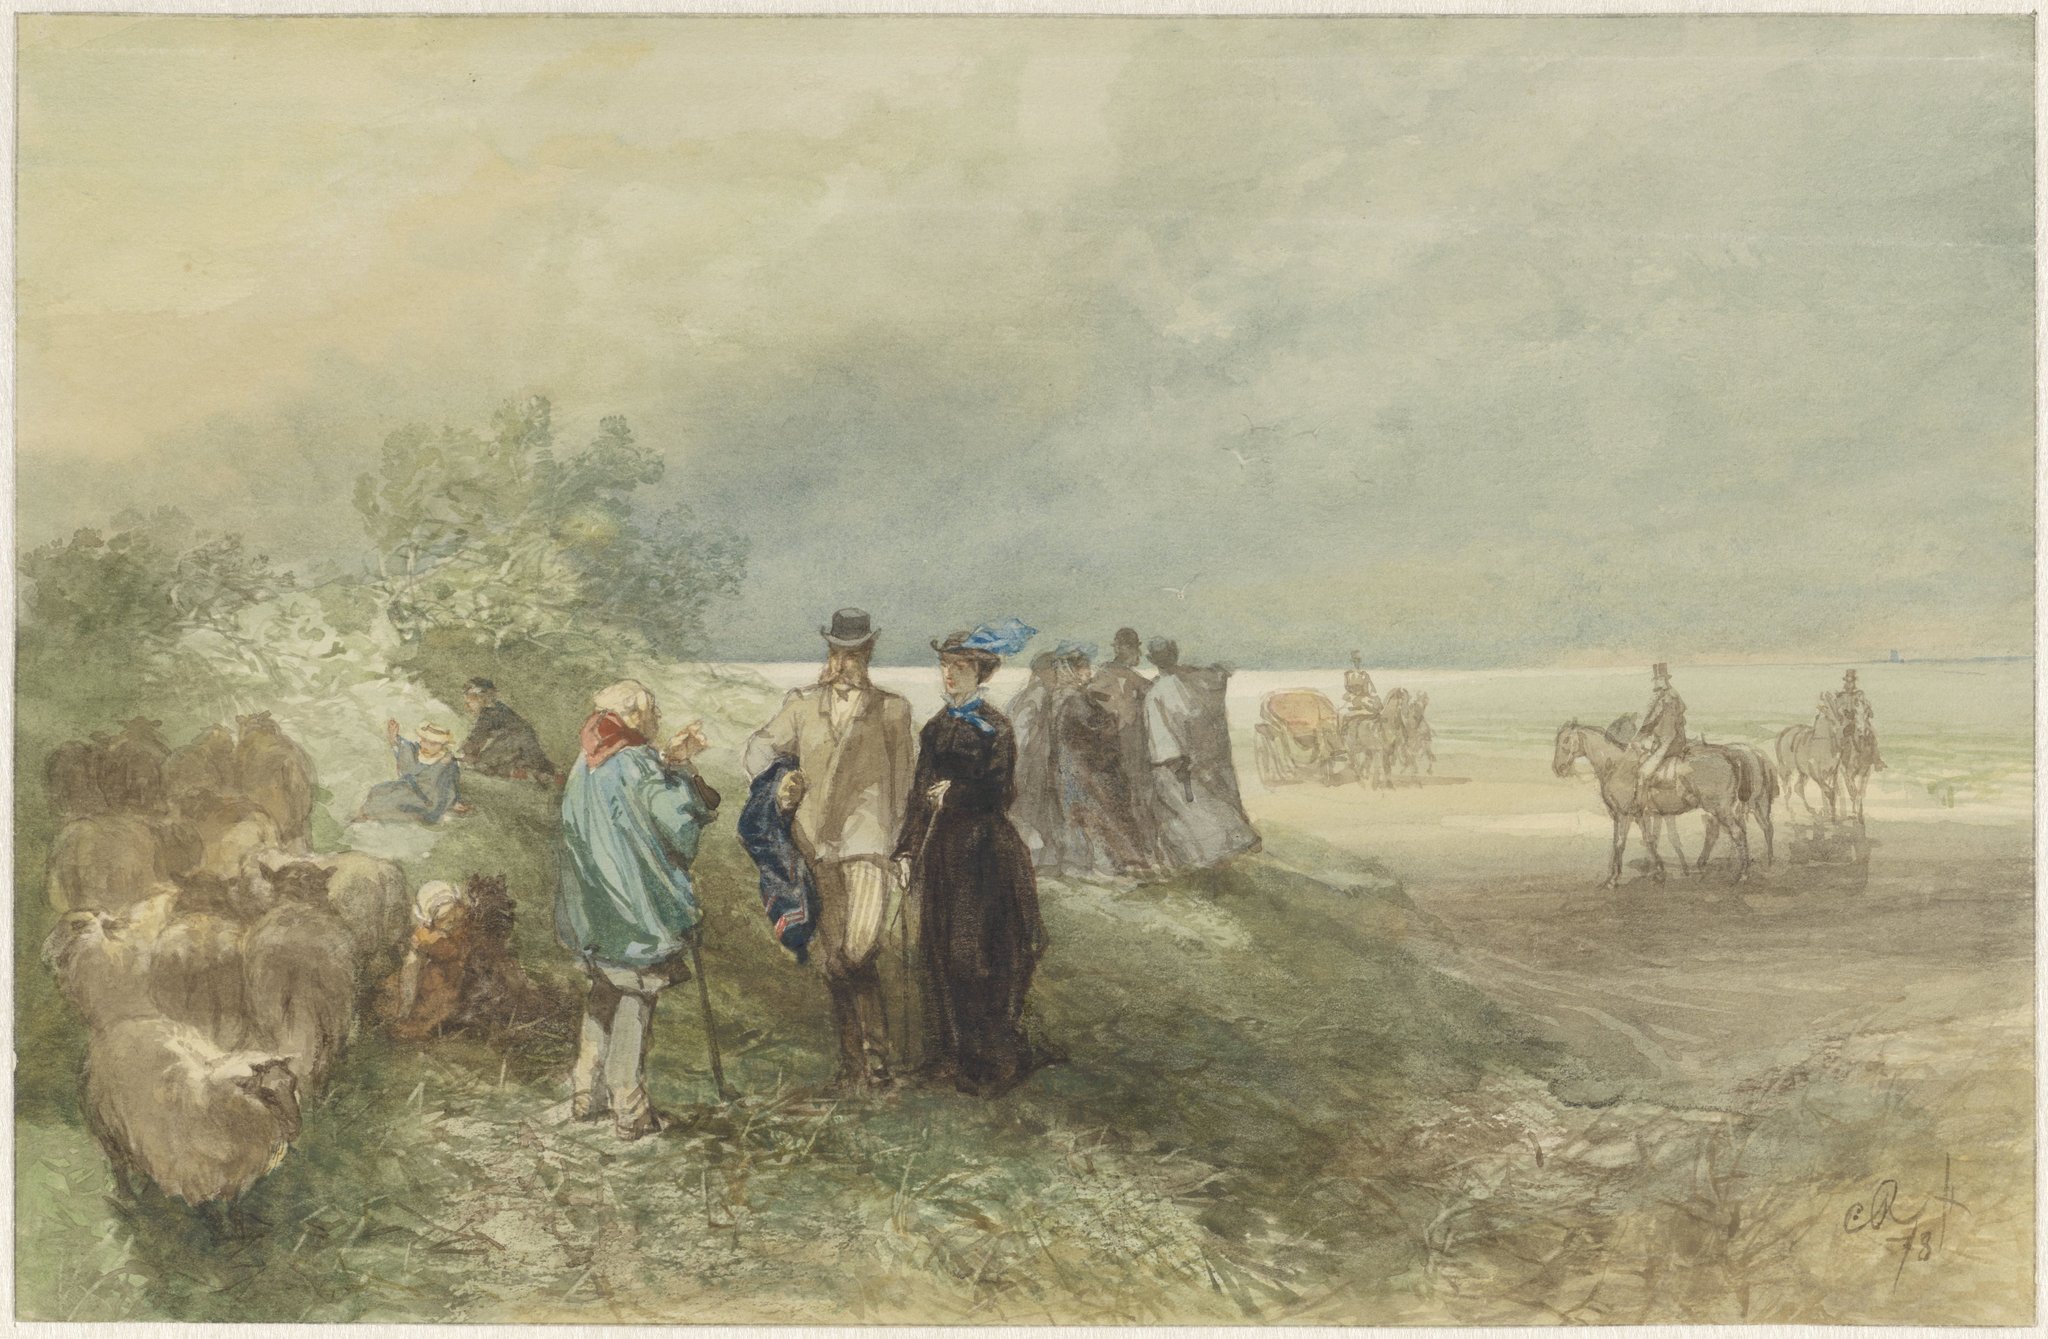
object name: watercolor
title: Aan de kust van de Zuiderzee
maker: charles rochussen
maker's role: draughtsman, painter, print maker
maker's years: 1814-1894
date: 1878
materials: chalk, paper, watercolor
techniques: brush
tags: dune coast, walking, hiking (recreation), herding, herdsman, herdswoman, shepherd, shepherdess, cowherd, etc., sea (seascape), sheep, horse-racing, beach